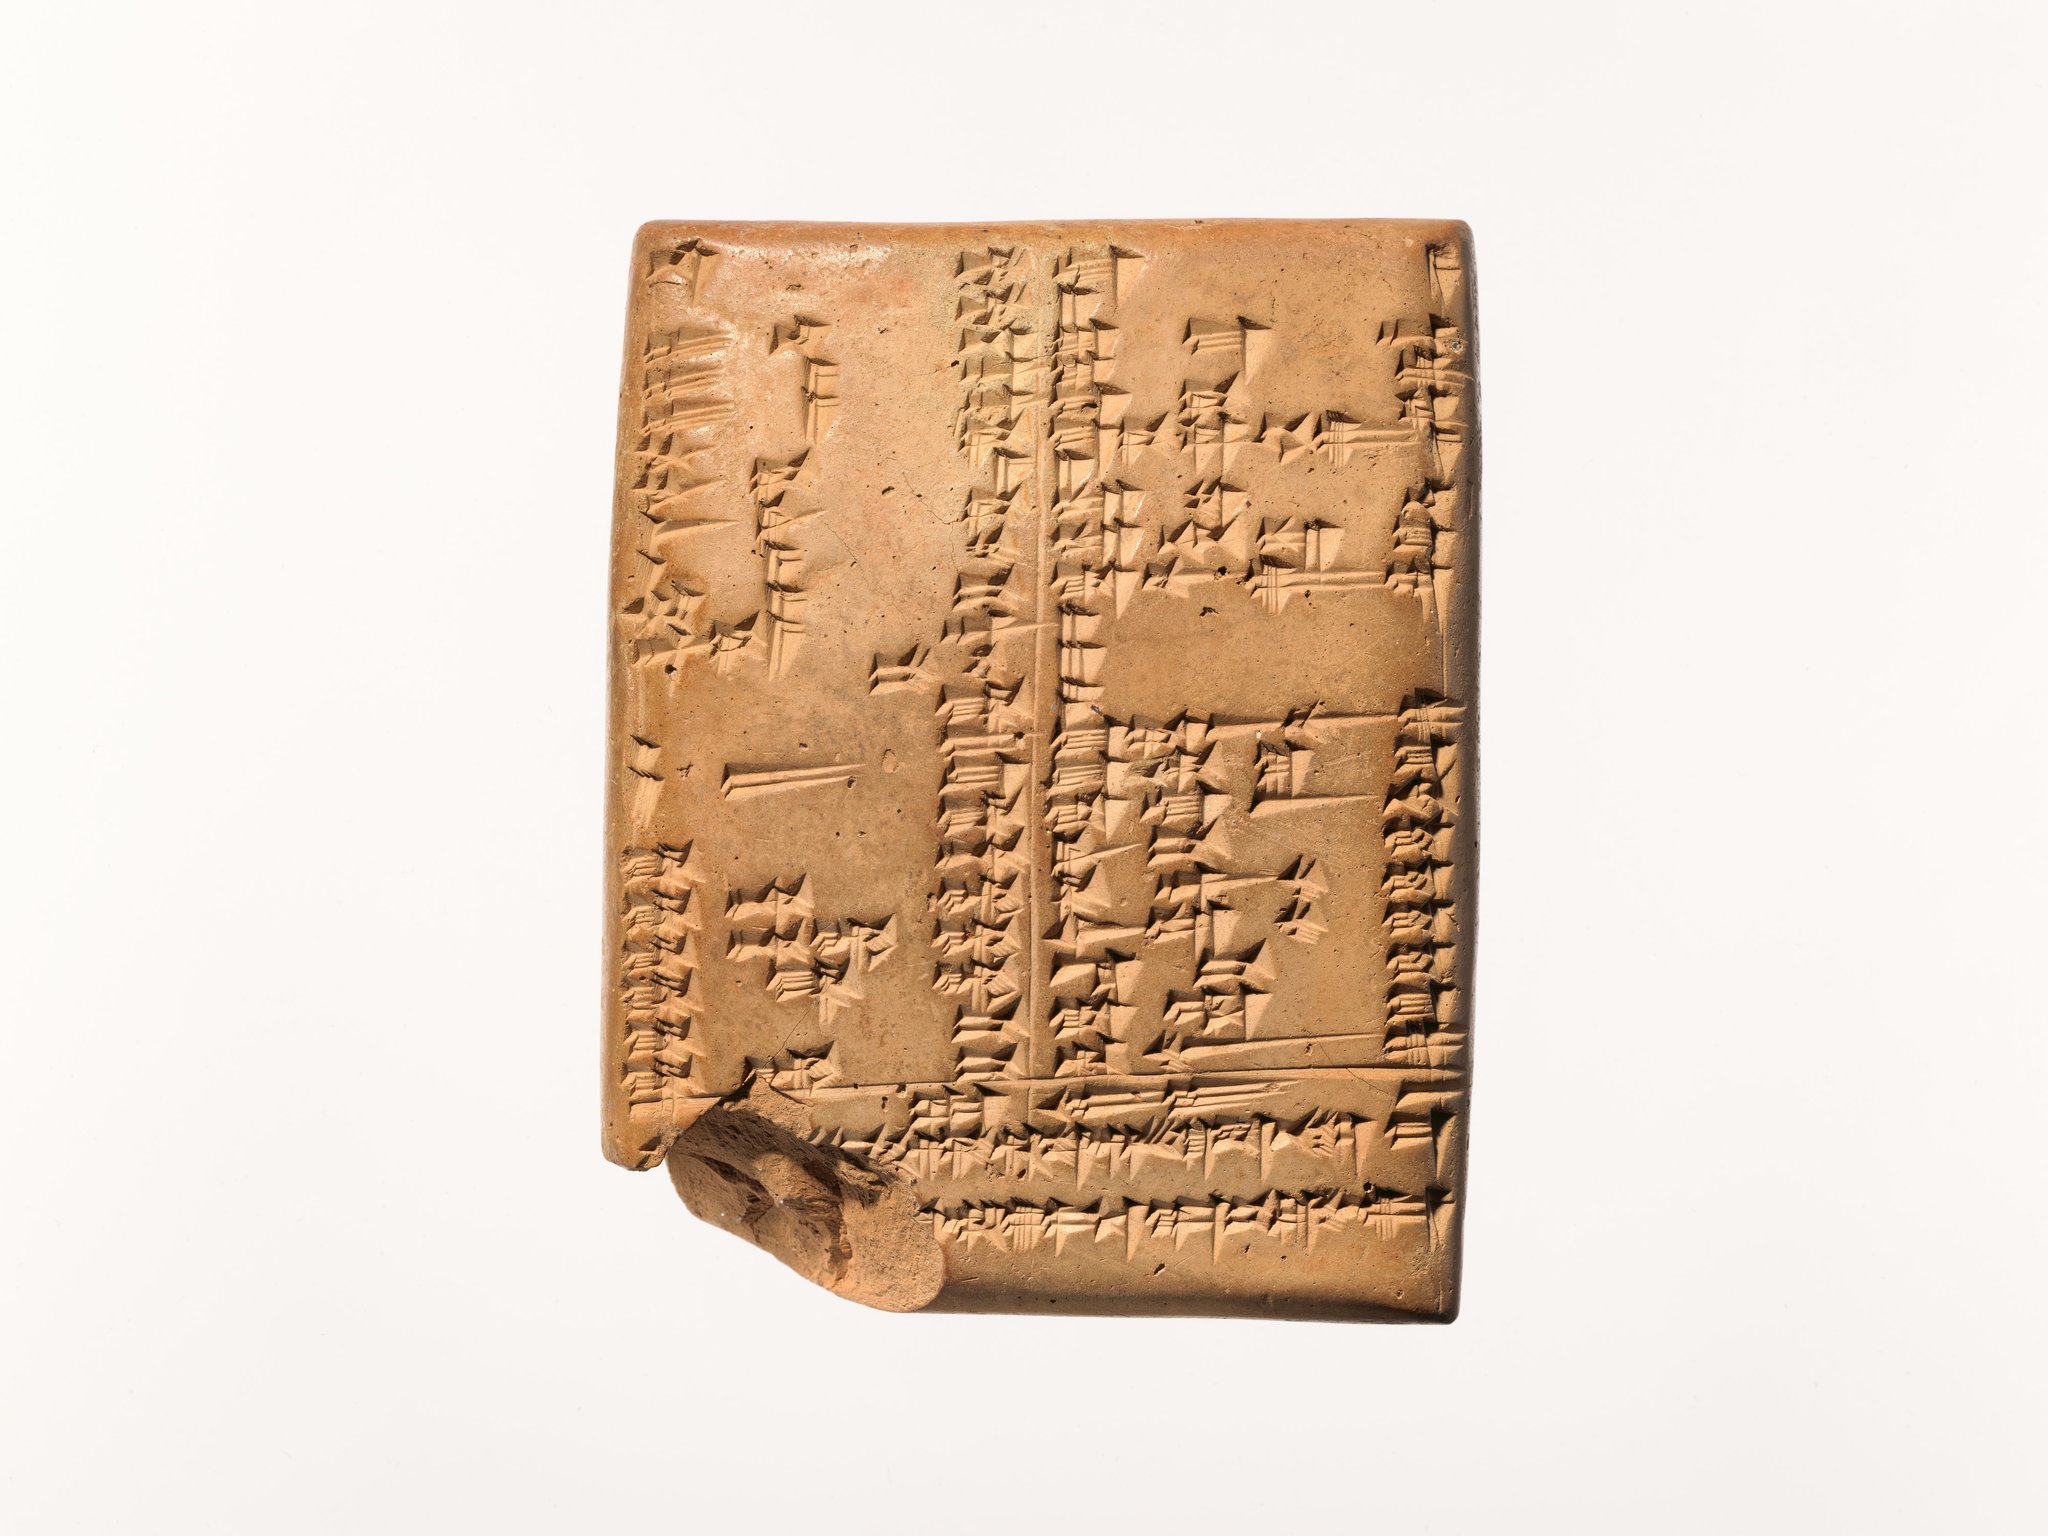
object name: cuneiform tablet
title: Cuneiform tablet: Late Babylonian grammatical text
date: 333-1 BCE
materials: clay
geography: mesopotamia